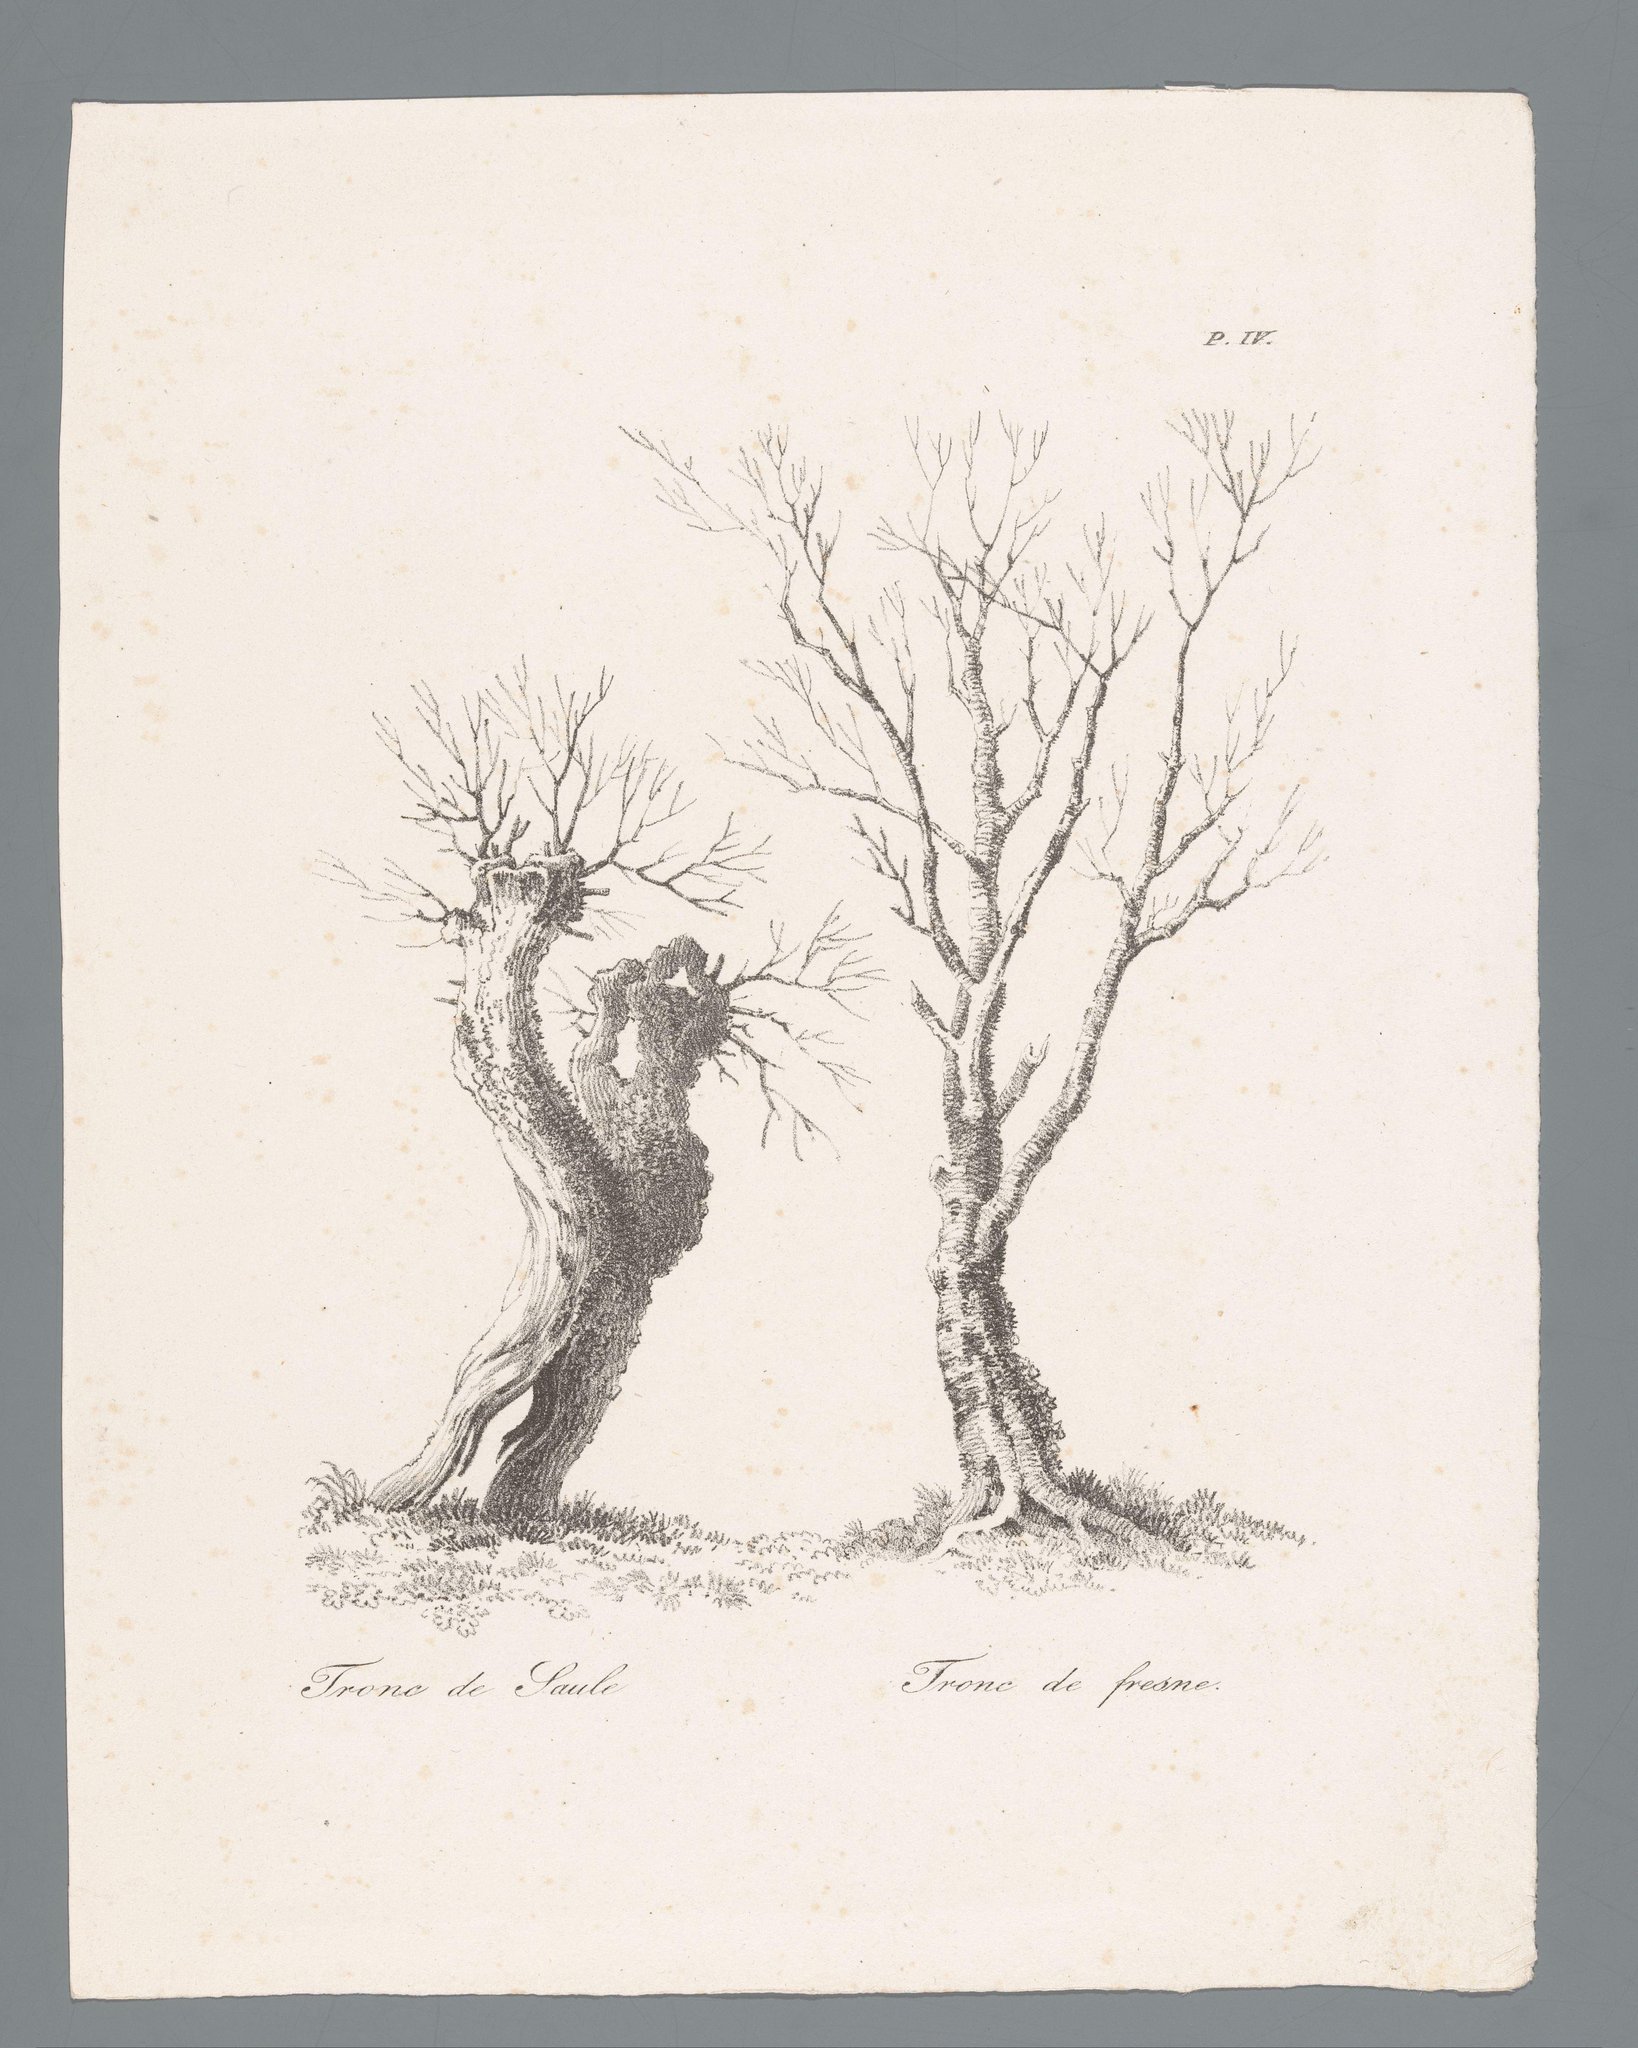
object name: print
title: Trone de saule, trone de fresne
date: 1820-1833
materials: paper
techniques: lithograph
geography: paris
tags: trees: ash-tree, trees: willow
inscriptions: collector's mark: Lugt 2228